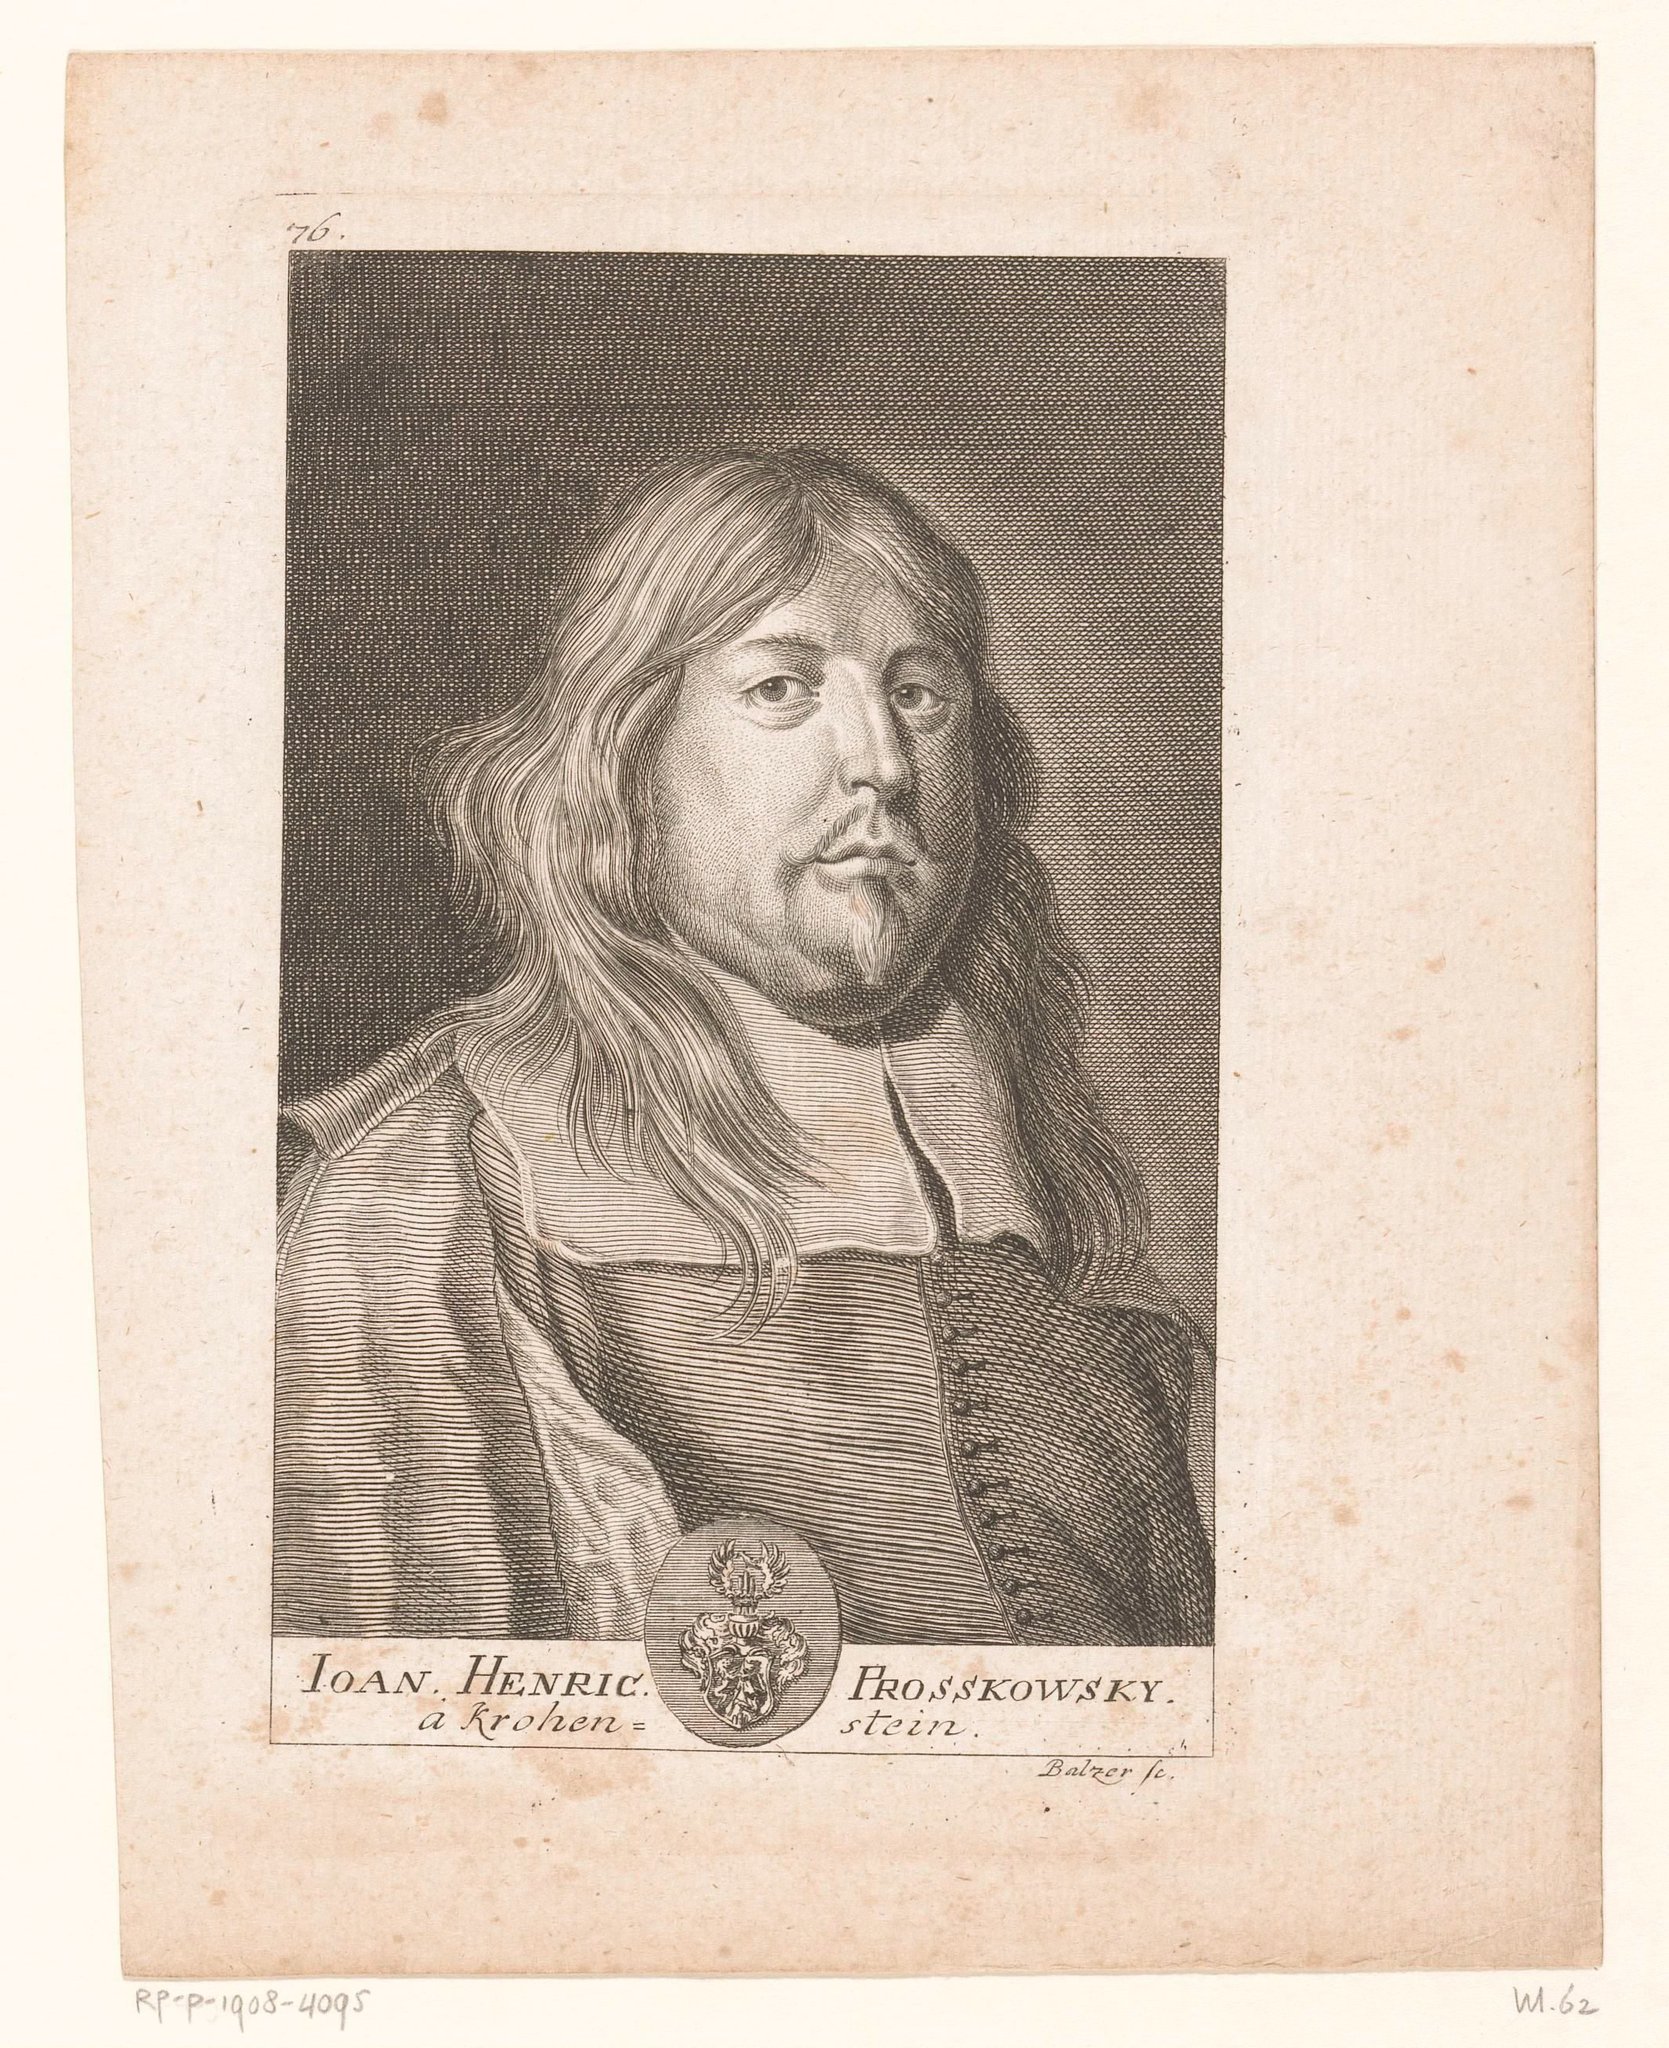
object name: print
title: Portret van Joannes Henricus Prosskowsky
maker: jan balzer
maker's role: print maker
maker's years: 1736-1799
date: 1746-1799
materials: paper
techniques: engraving, etching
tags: historical persons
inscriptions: collector's mark: Lugt 2228